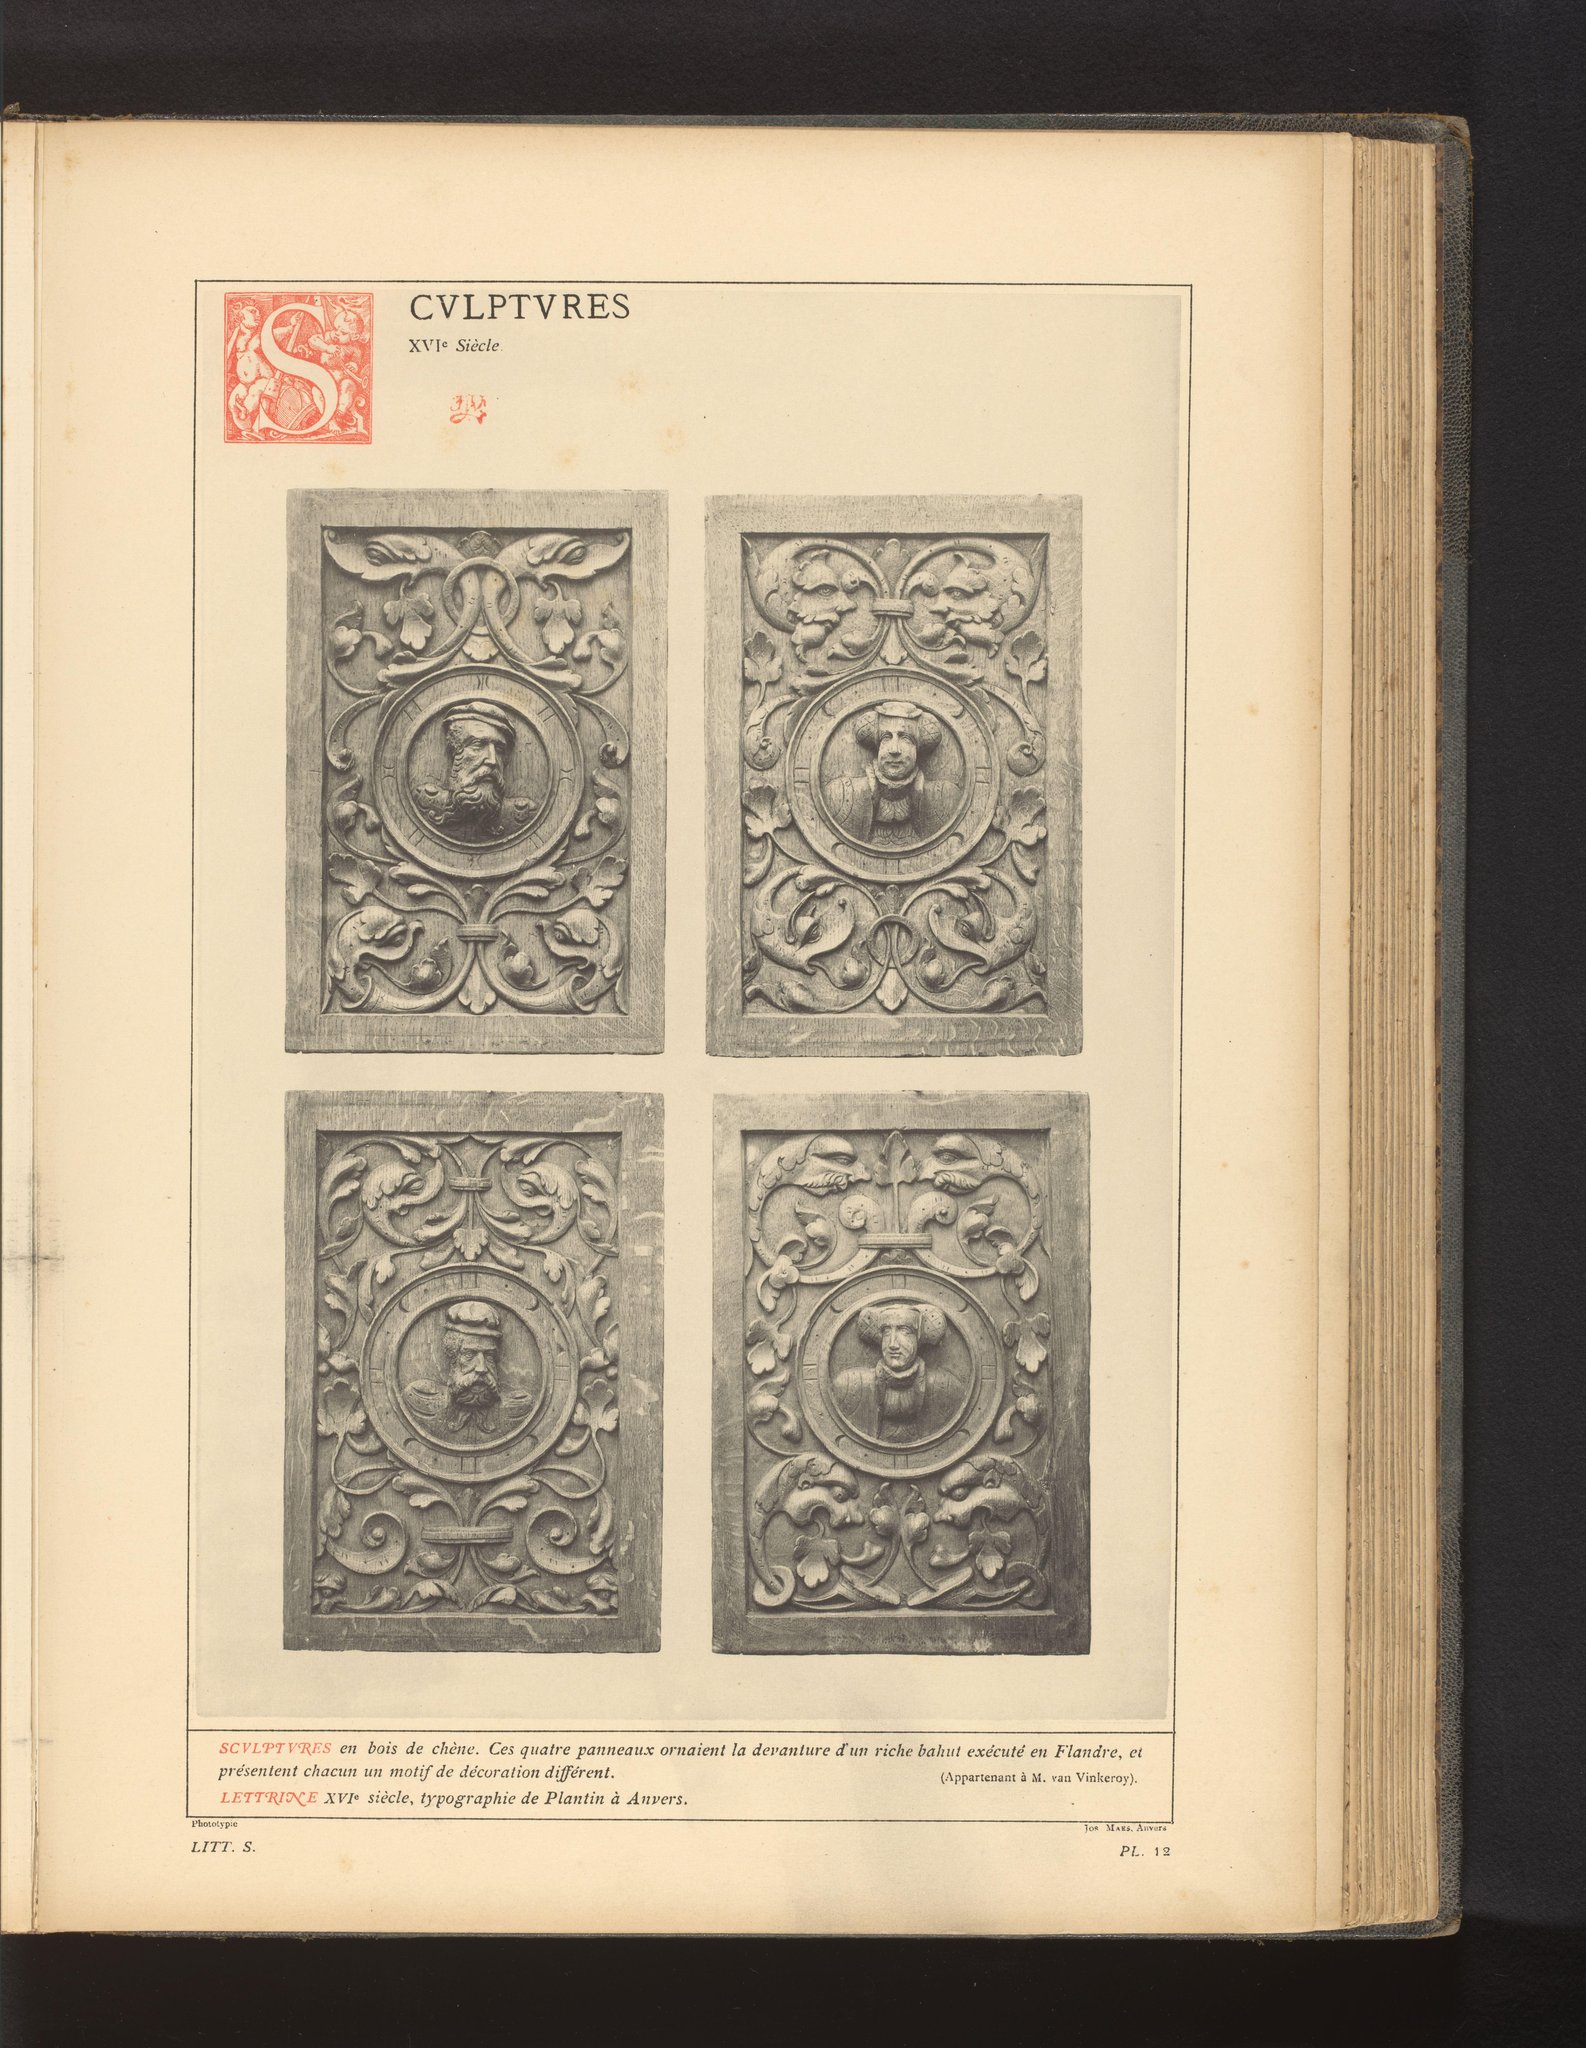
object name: photomechanical print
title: Sculptures, XVIe Siècle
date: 1876-1881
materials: paper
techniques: photograph, photolithography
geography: antwerp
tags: sculpture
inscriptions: inscription: ‘LITT. S. - PL. 12.’, monogram: ‘JJvY’, inscription: ‘SCULPTURES en bois de chène (...)’